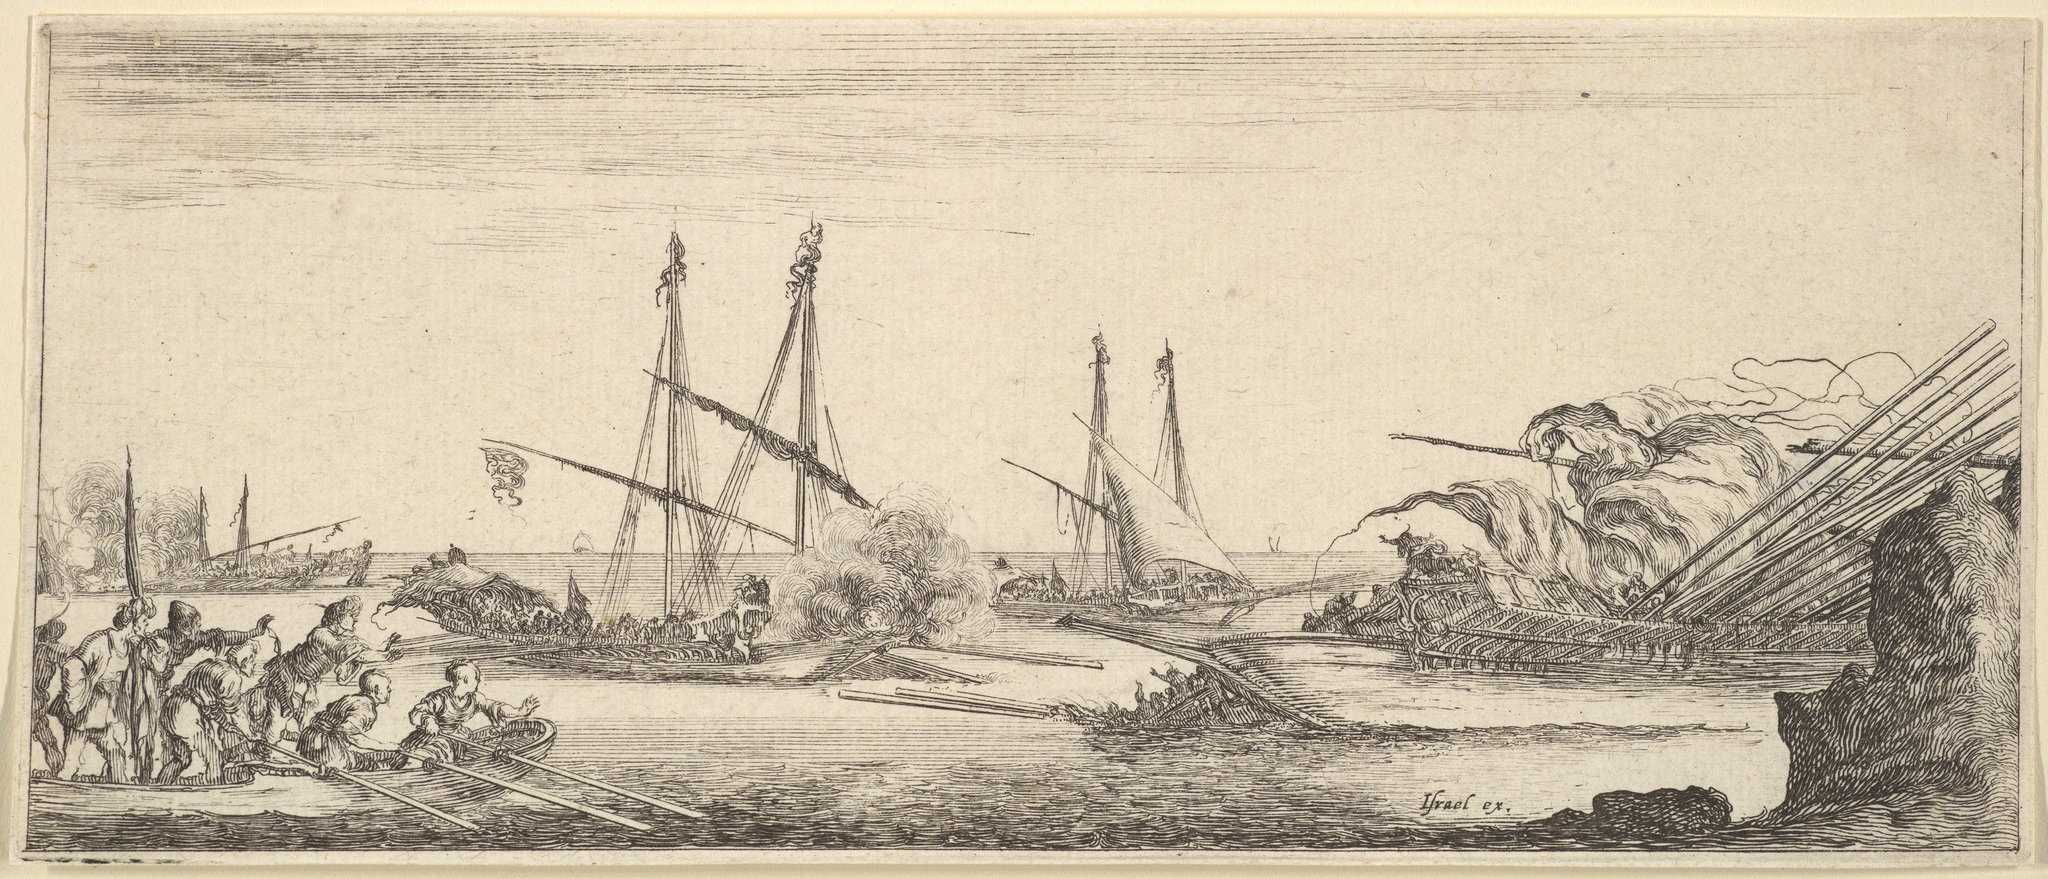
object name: print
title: A naval battle, a rowboat full of men to left, a sinking ship to right, two galleys battling in center, other ships battle to left in the background, from "Various Landscapes" (Divers Paysages)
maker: stefano della bella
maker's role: artist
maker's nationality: italian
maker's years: 1610-1664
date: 1641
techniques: etching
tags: battles,men,ships